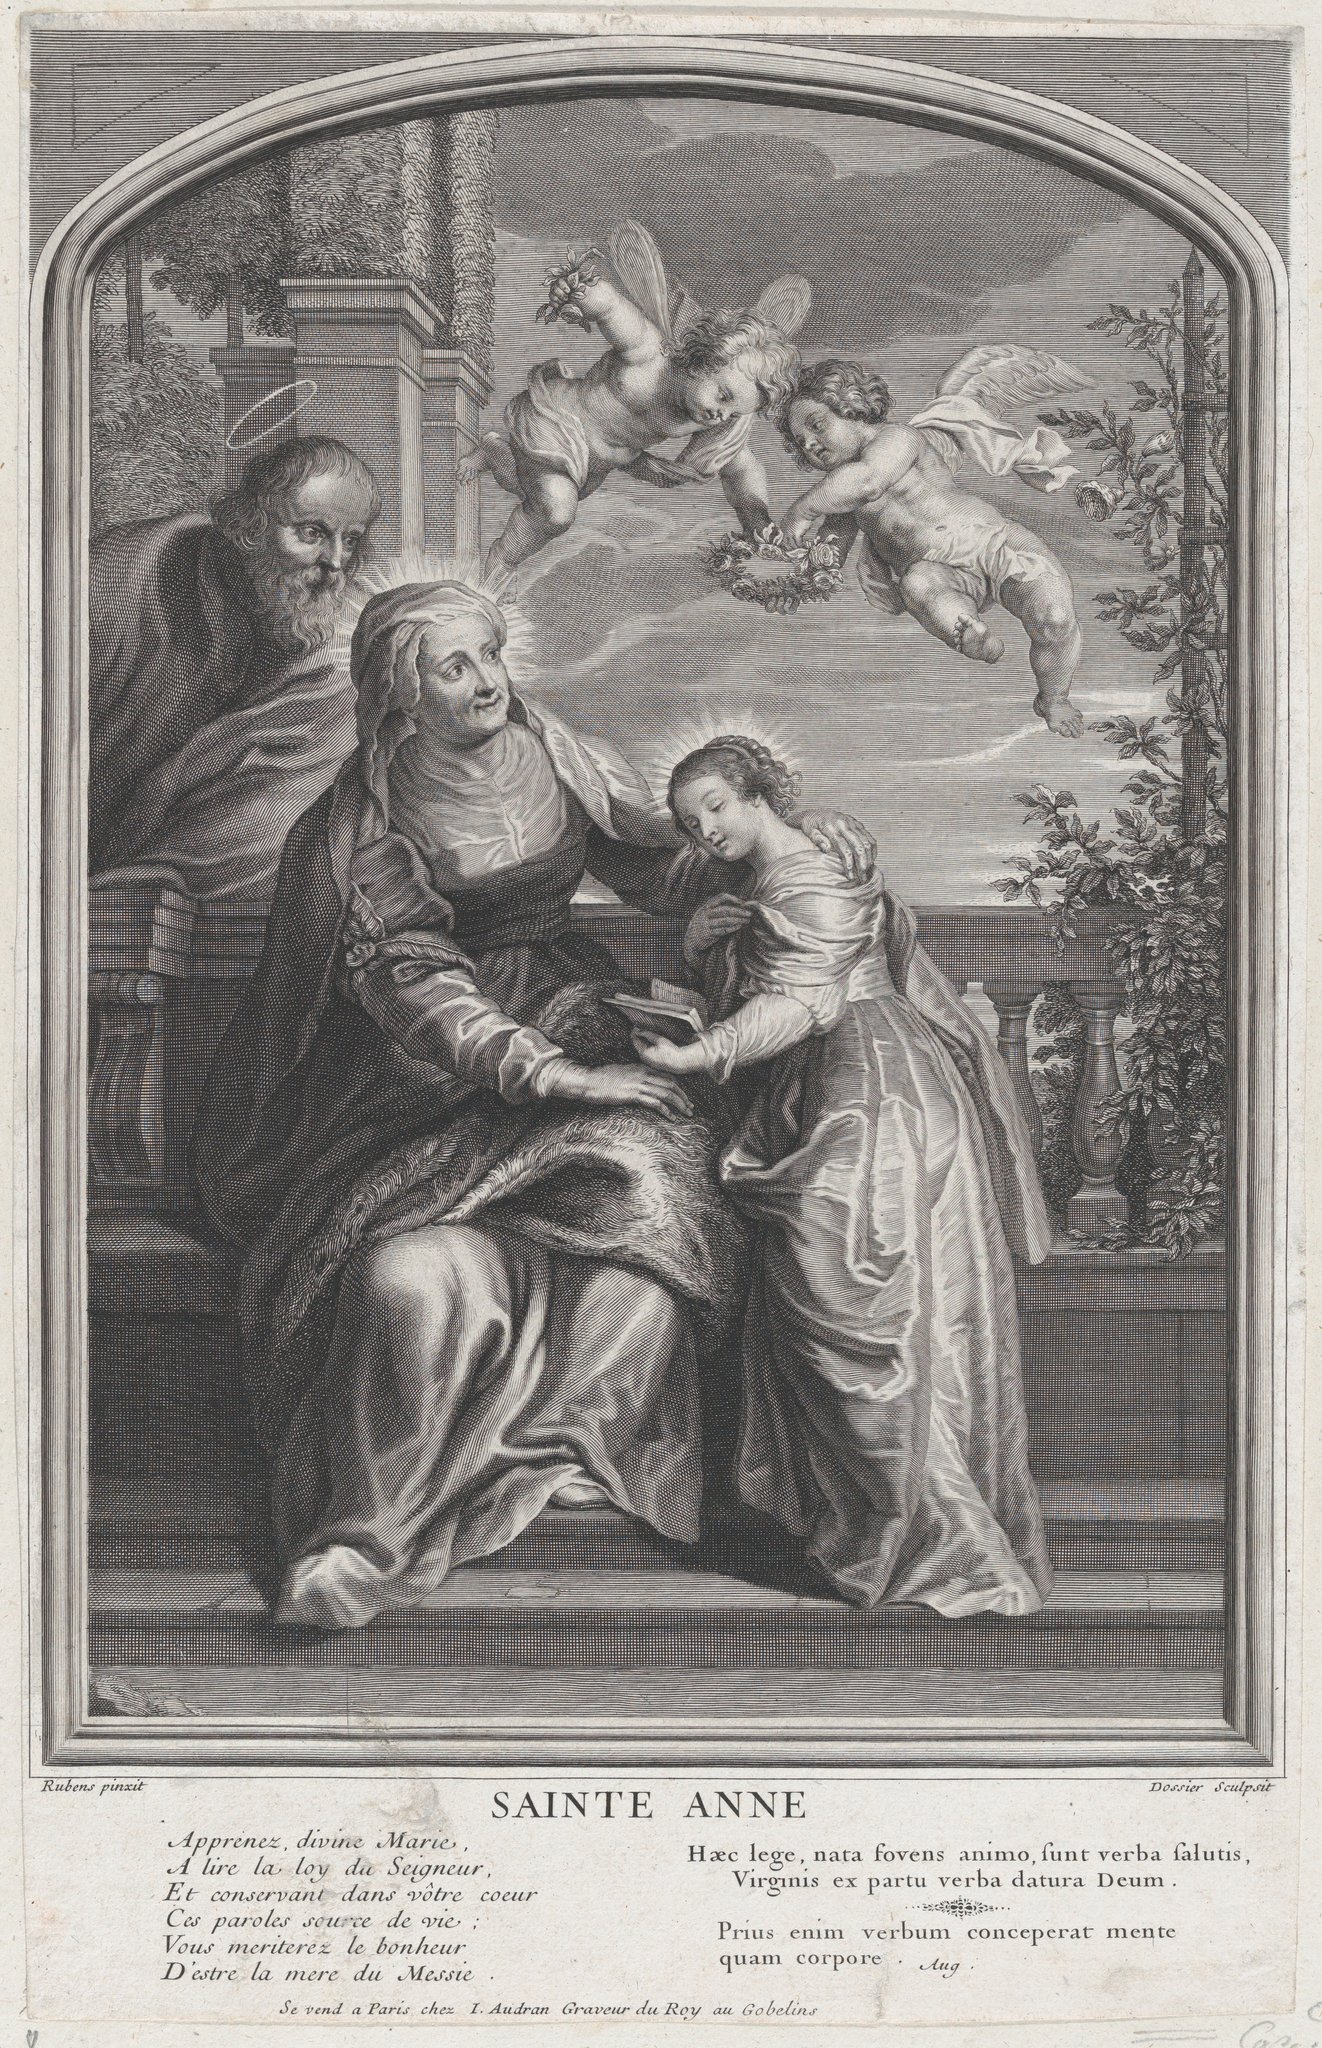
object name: print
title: The education of the Virgin, with Saint Anne and the Virgin Mary reading with two putti overhead and Saint Joachim behind them at left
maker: michel dossier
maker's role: artist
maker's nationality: french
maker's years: 1684-1750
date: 1700-1750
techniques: engraving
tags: saint anne,virgin mary,saints